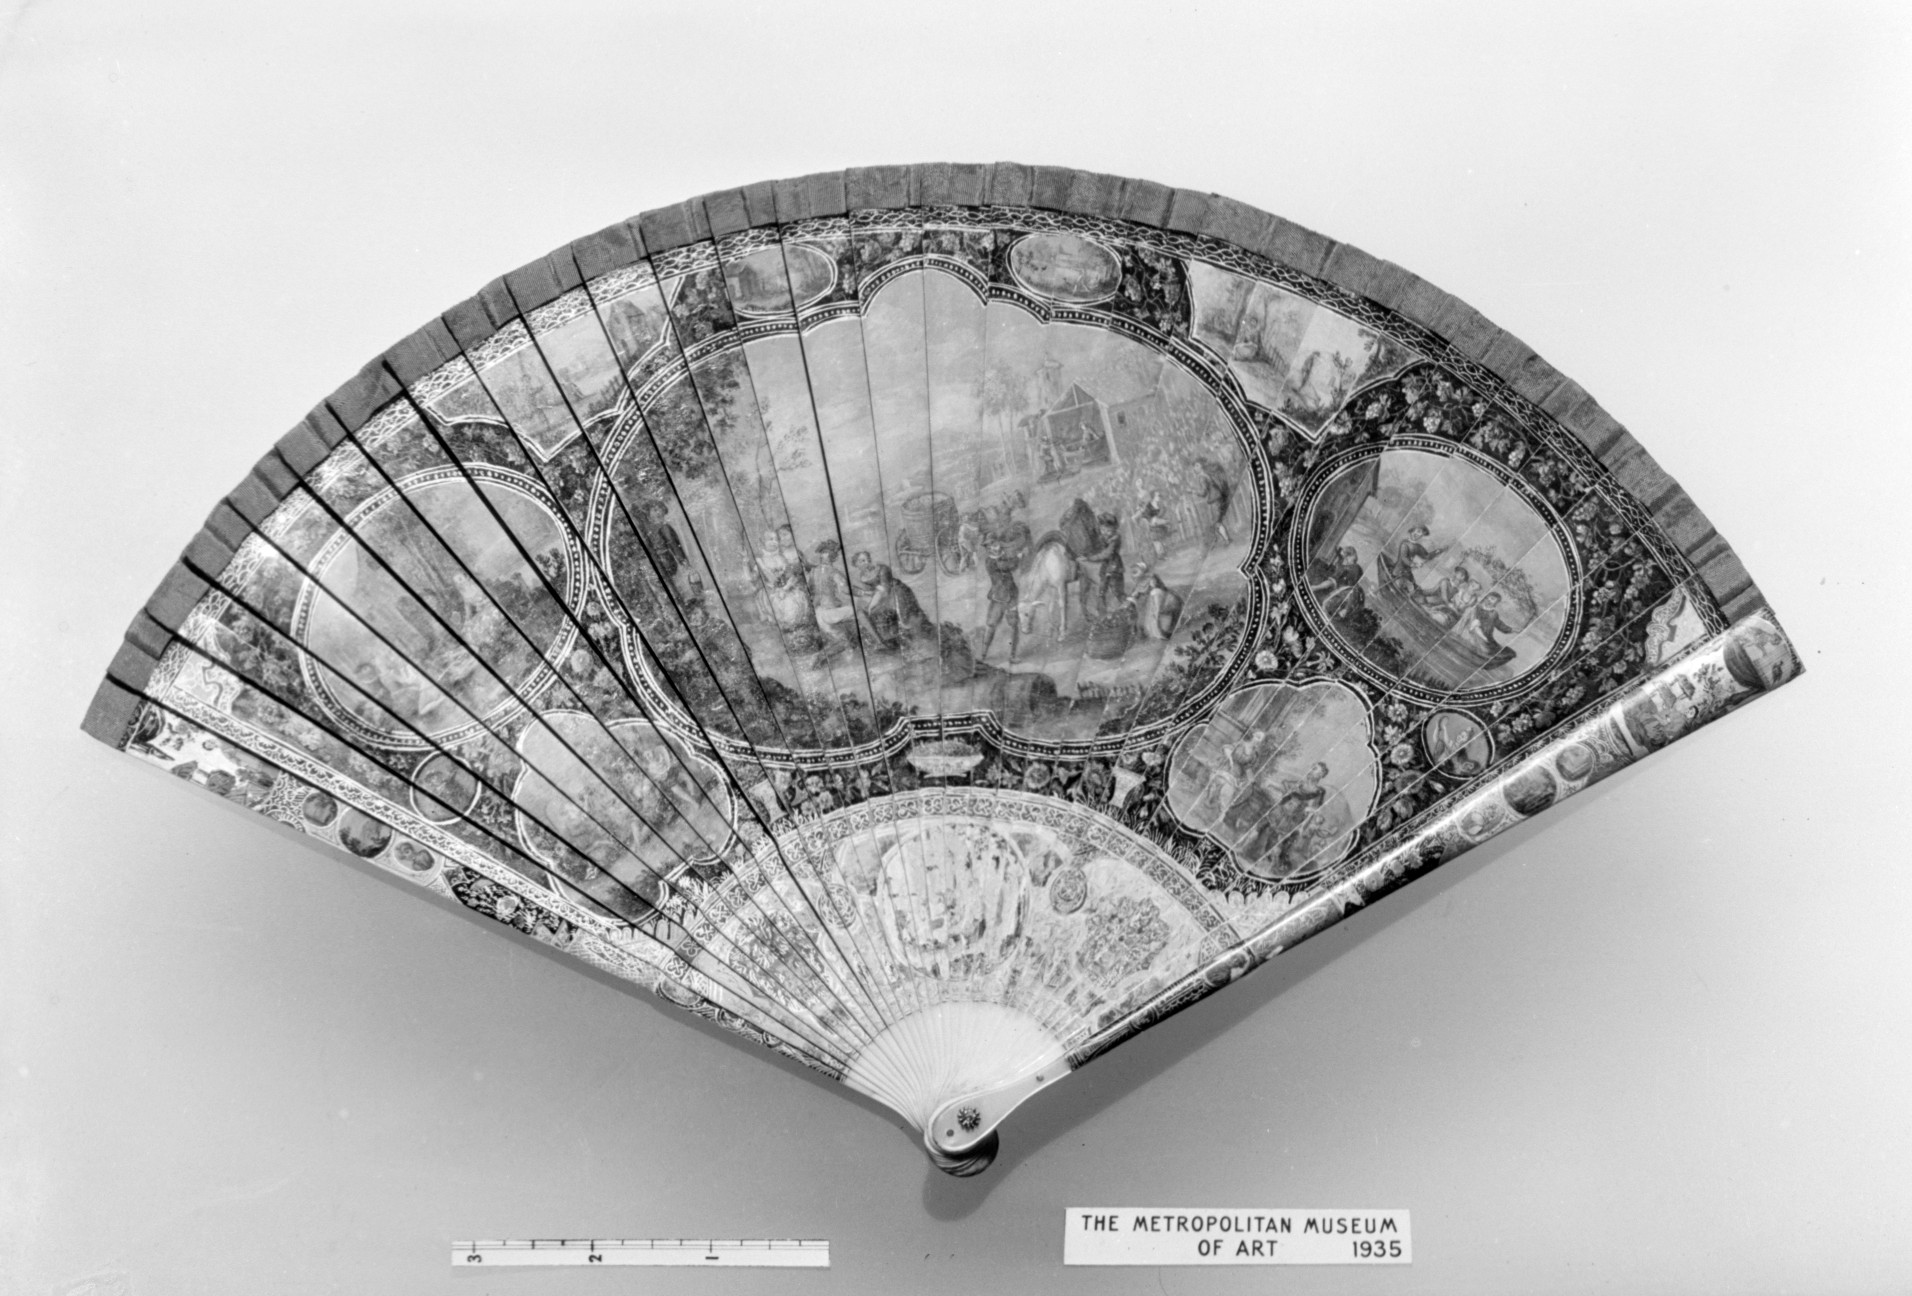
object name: fan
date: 1701-1733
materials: ivory, mother of pearl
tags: men,women,boats